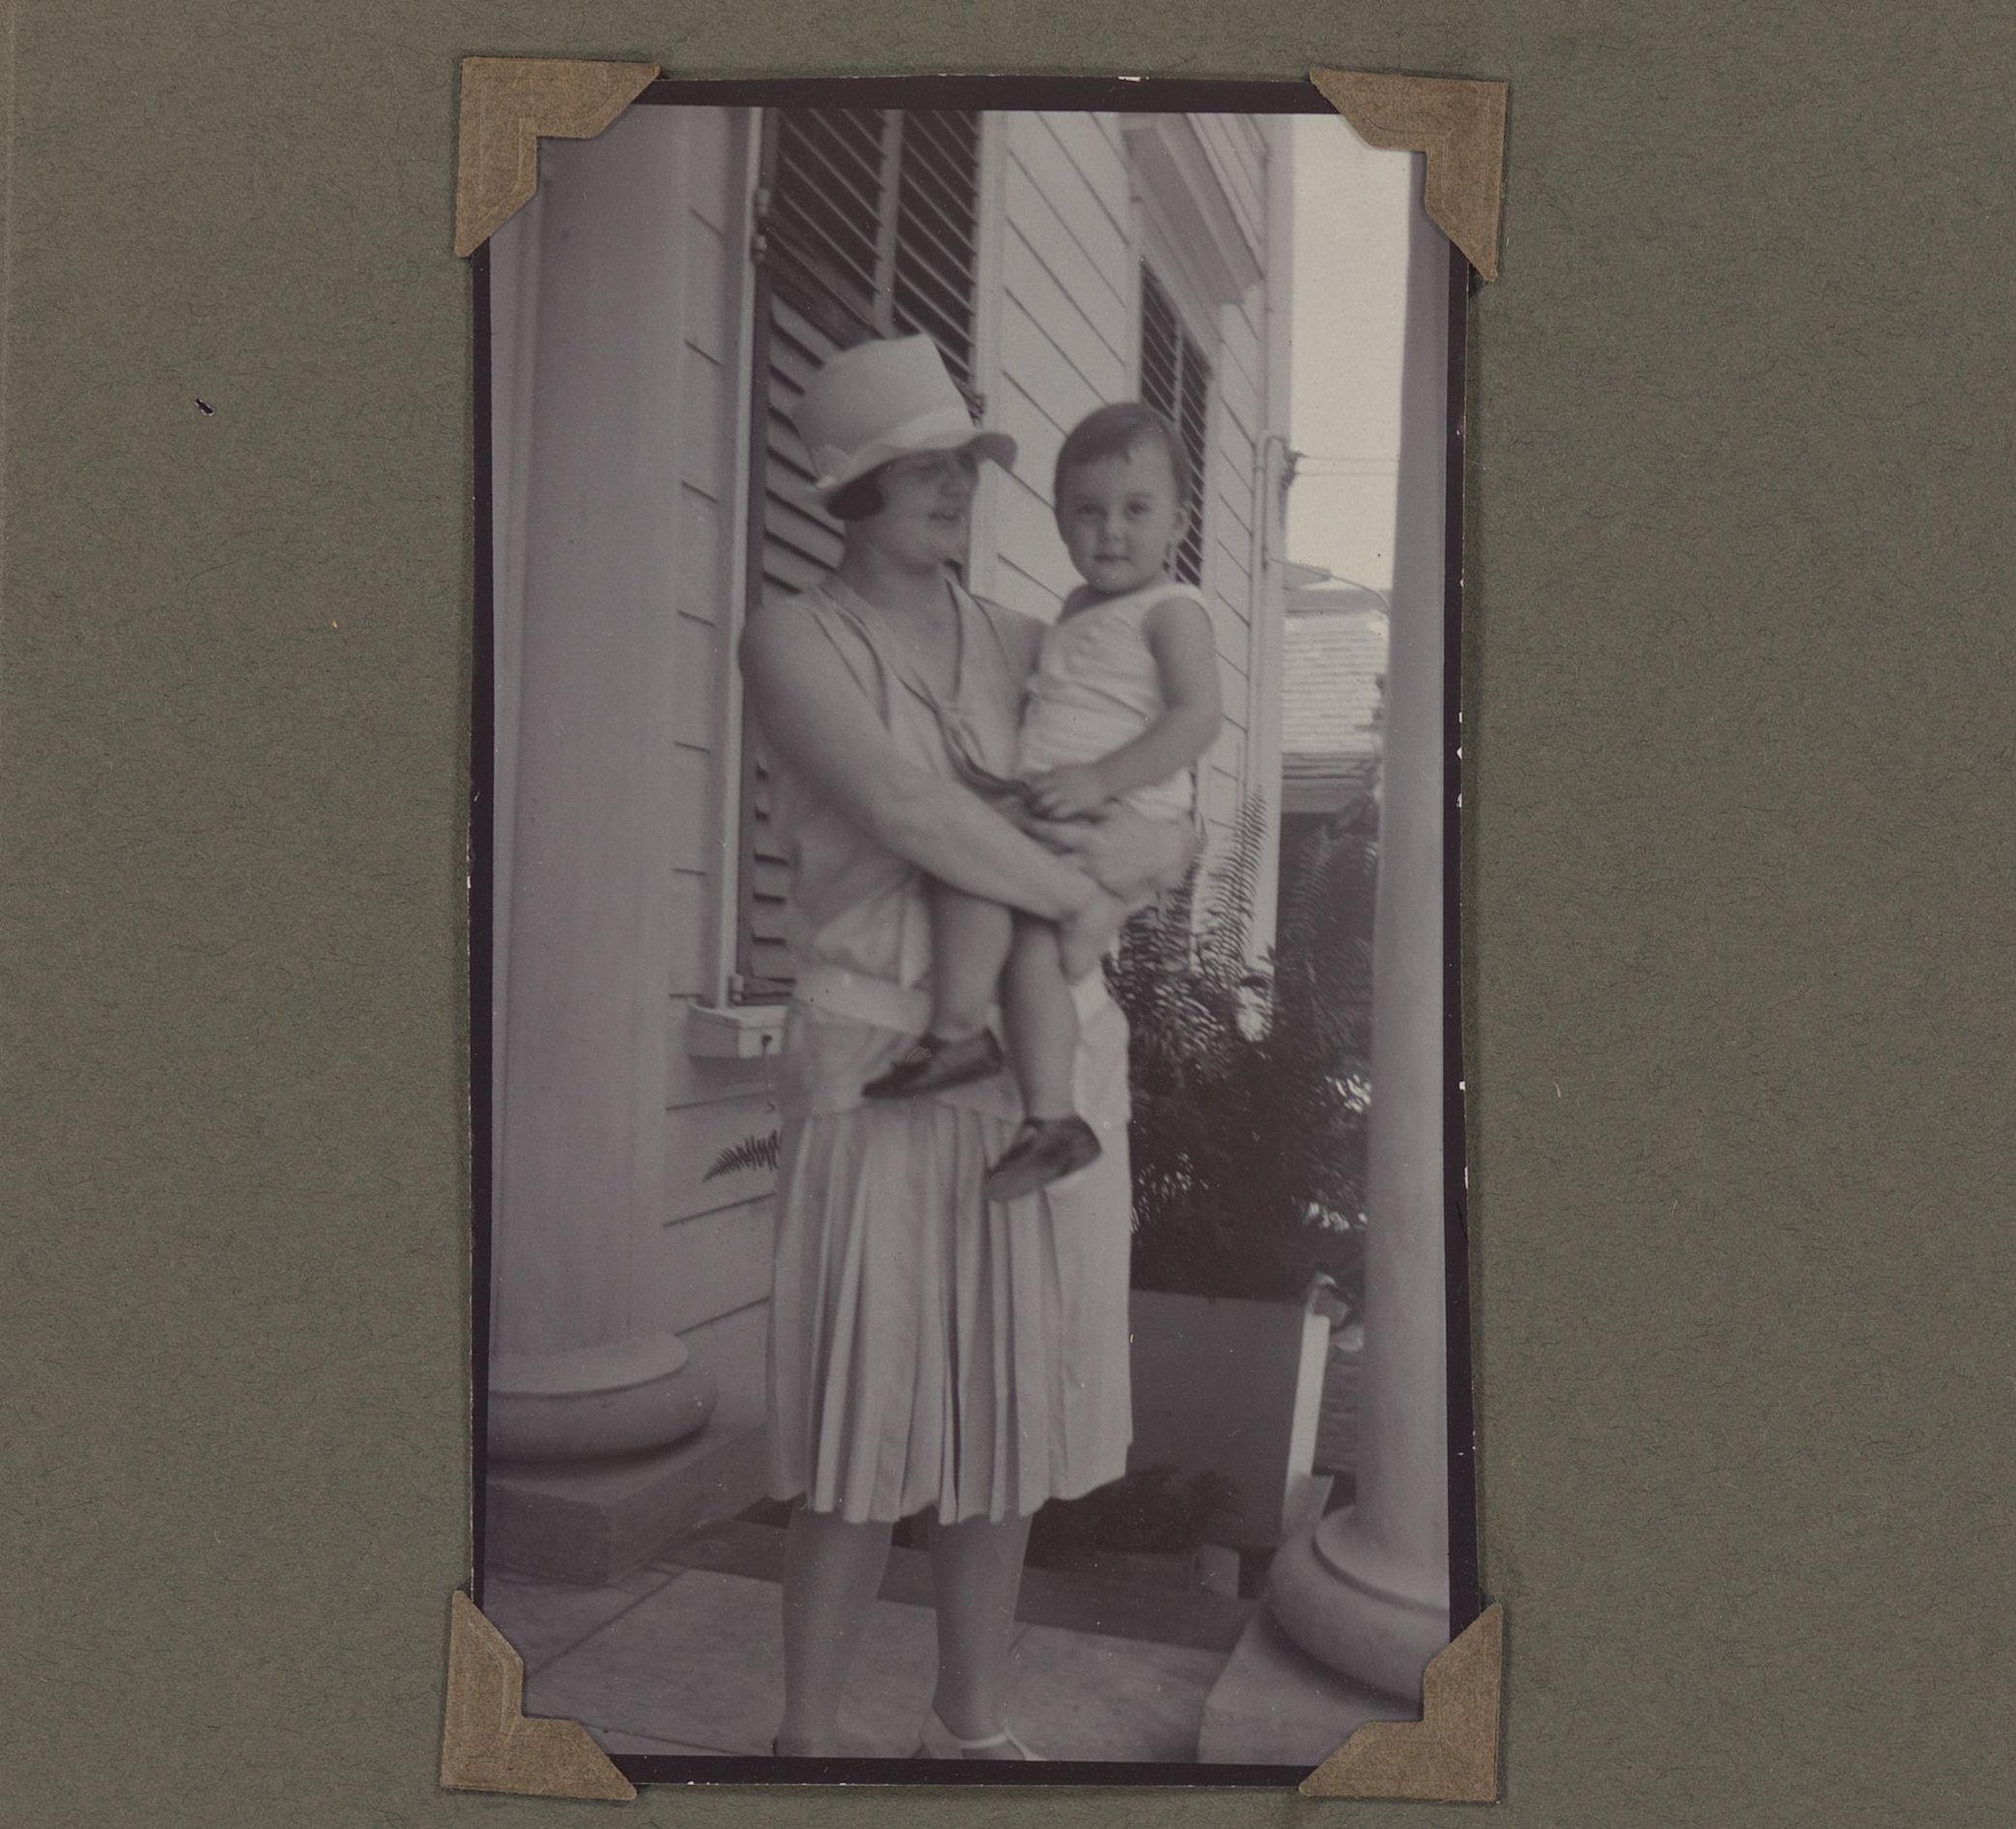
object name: photograph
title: Familiefoto van het gezin Jetten te Moengo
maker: Anonymous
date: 1925-1927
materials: photographic support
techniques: photography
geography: suriname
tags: jetten, familie, moengo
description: Familiefoto van het gezin Jetten te Moengo. Foto op een bladzijde van een los albumblad. Onderdeel van het ensemble met foto's van de familie van ingenieur Jetten in de mijnbouwstad Moengo in Suriname.